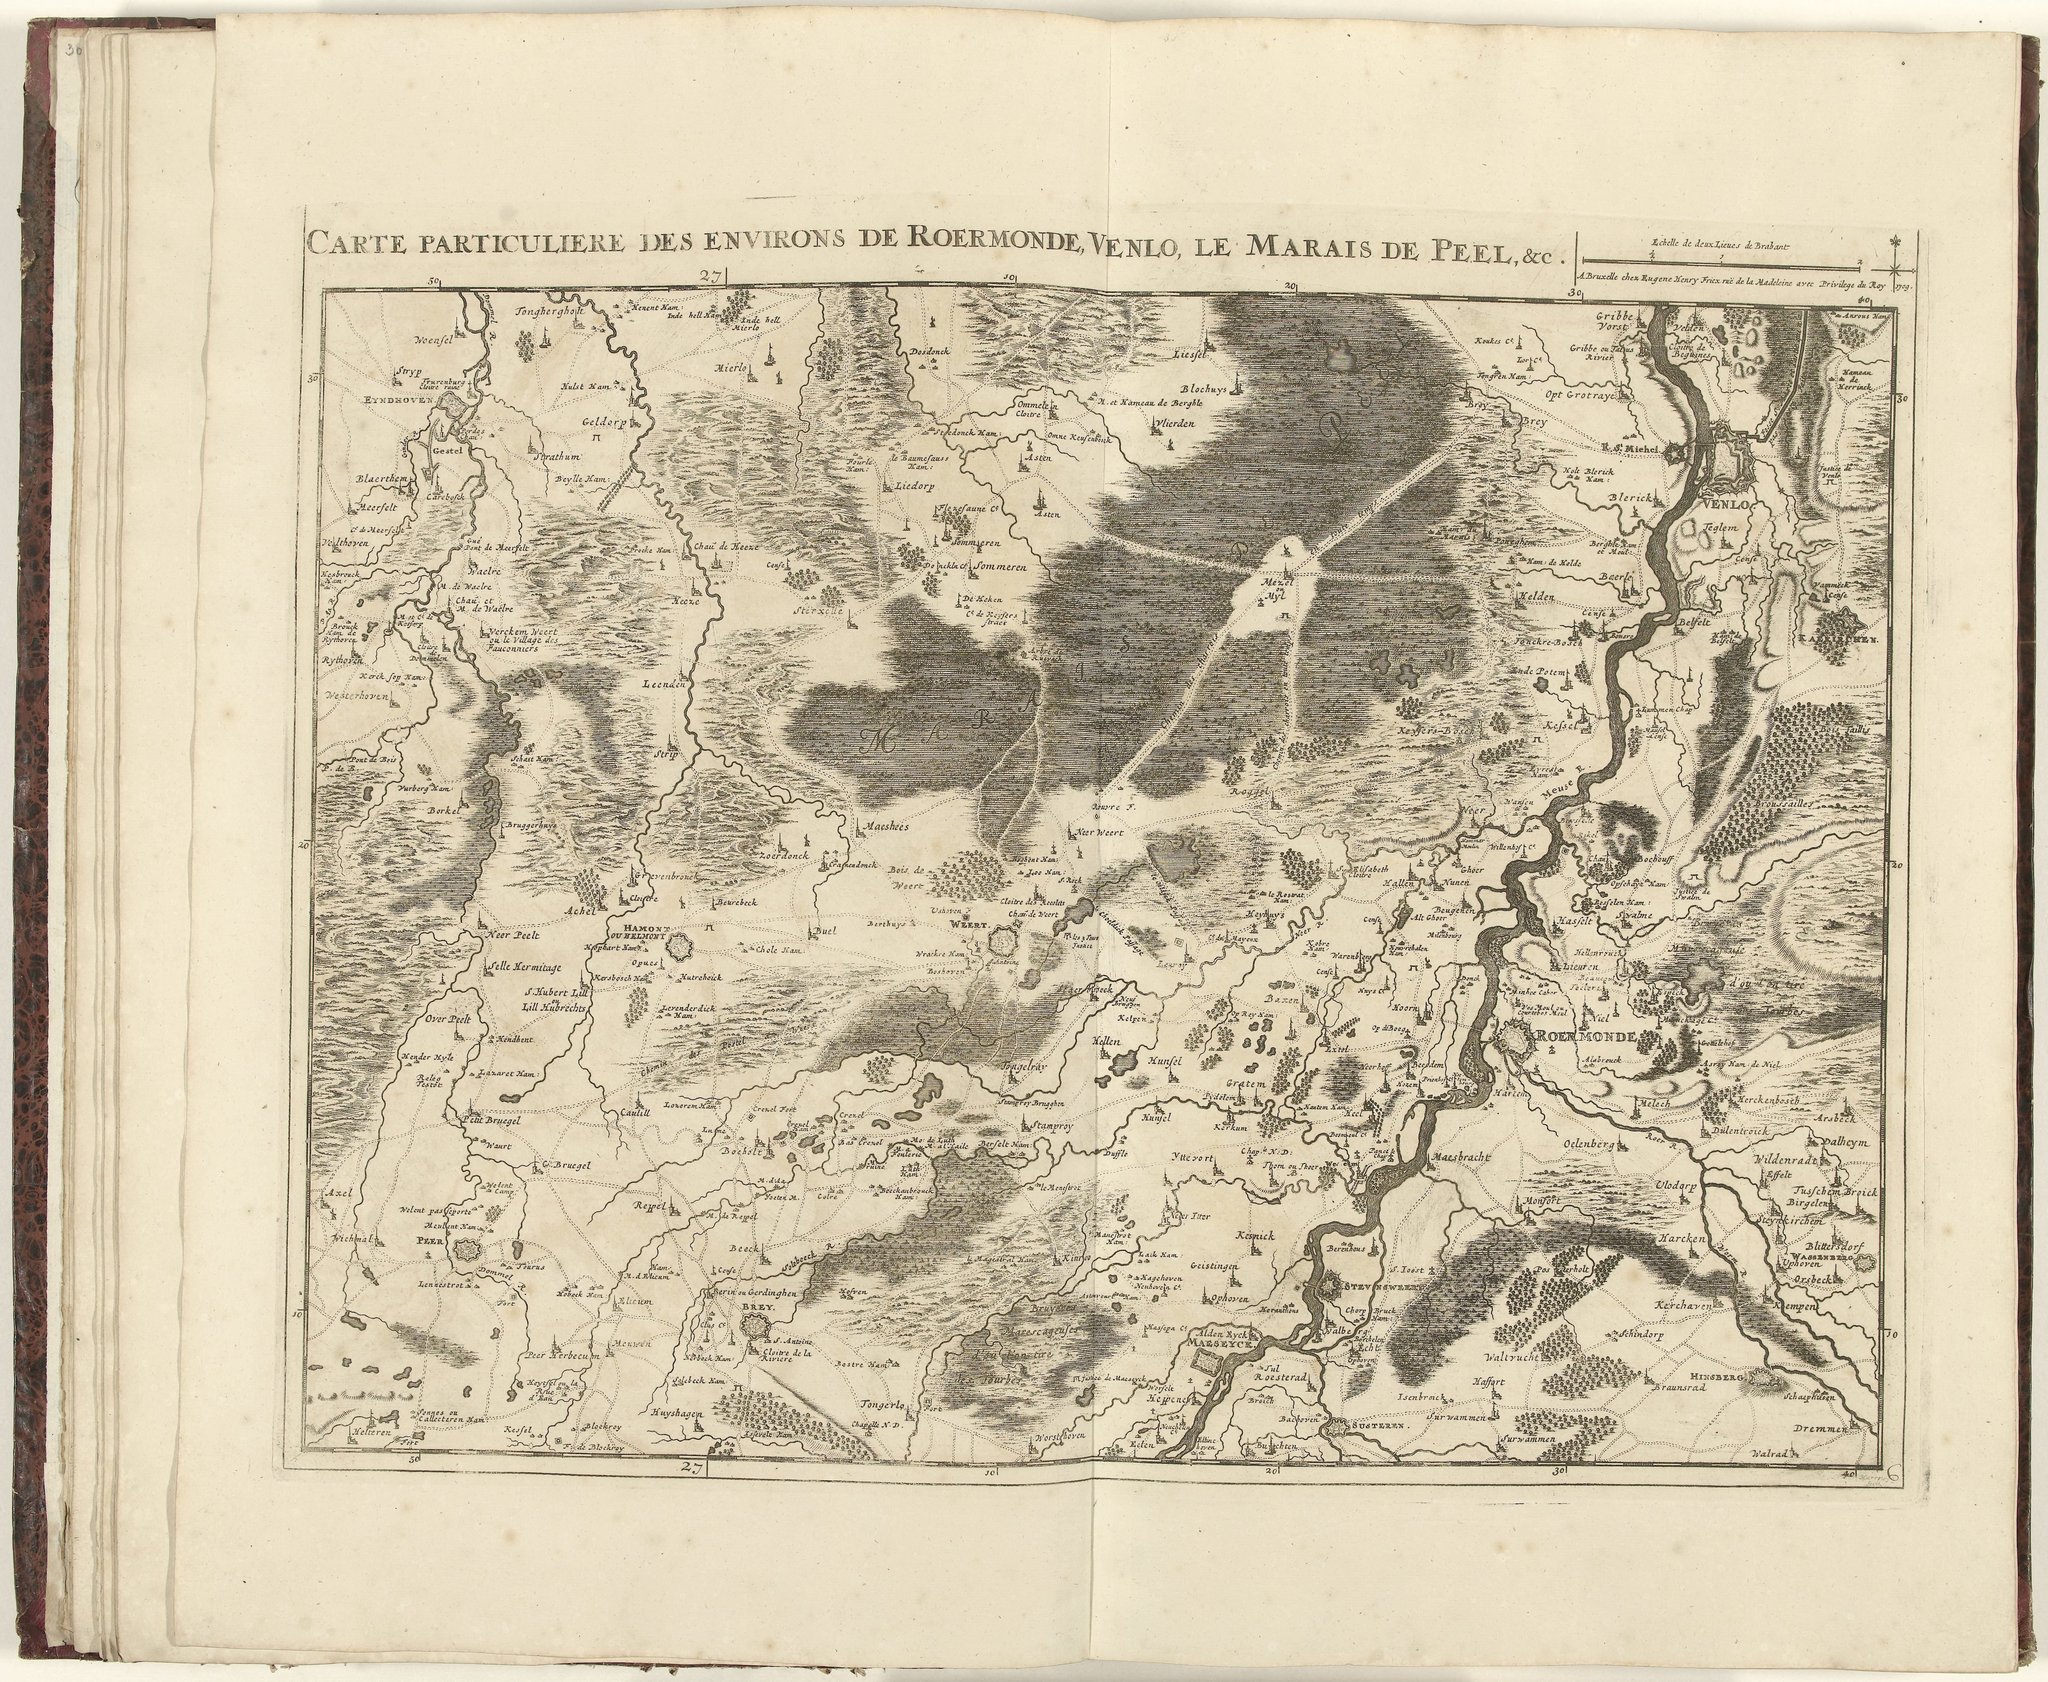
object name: map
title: Kaart van de omgeving van Roermond en Venlo, 1709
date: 1709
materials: paper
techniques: engraving, etching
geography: brussels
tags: maps of separate countries or regions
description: Kaart van de omgeving van Roermond en Venlo met de Peel, 1709. Onderdeel van een gebundelde verzameling van plannen van veldslagen en steden vermaard in de Spaanse Successieoorlog. Deze plaat behoort tot de eerste 24 platen die samen een zeer grote kaart van de Zuidelijke Nederlanden vormen.